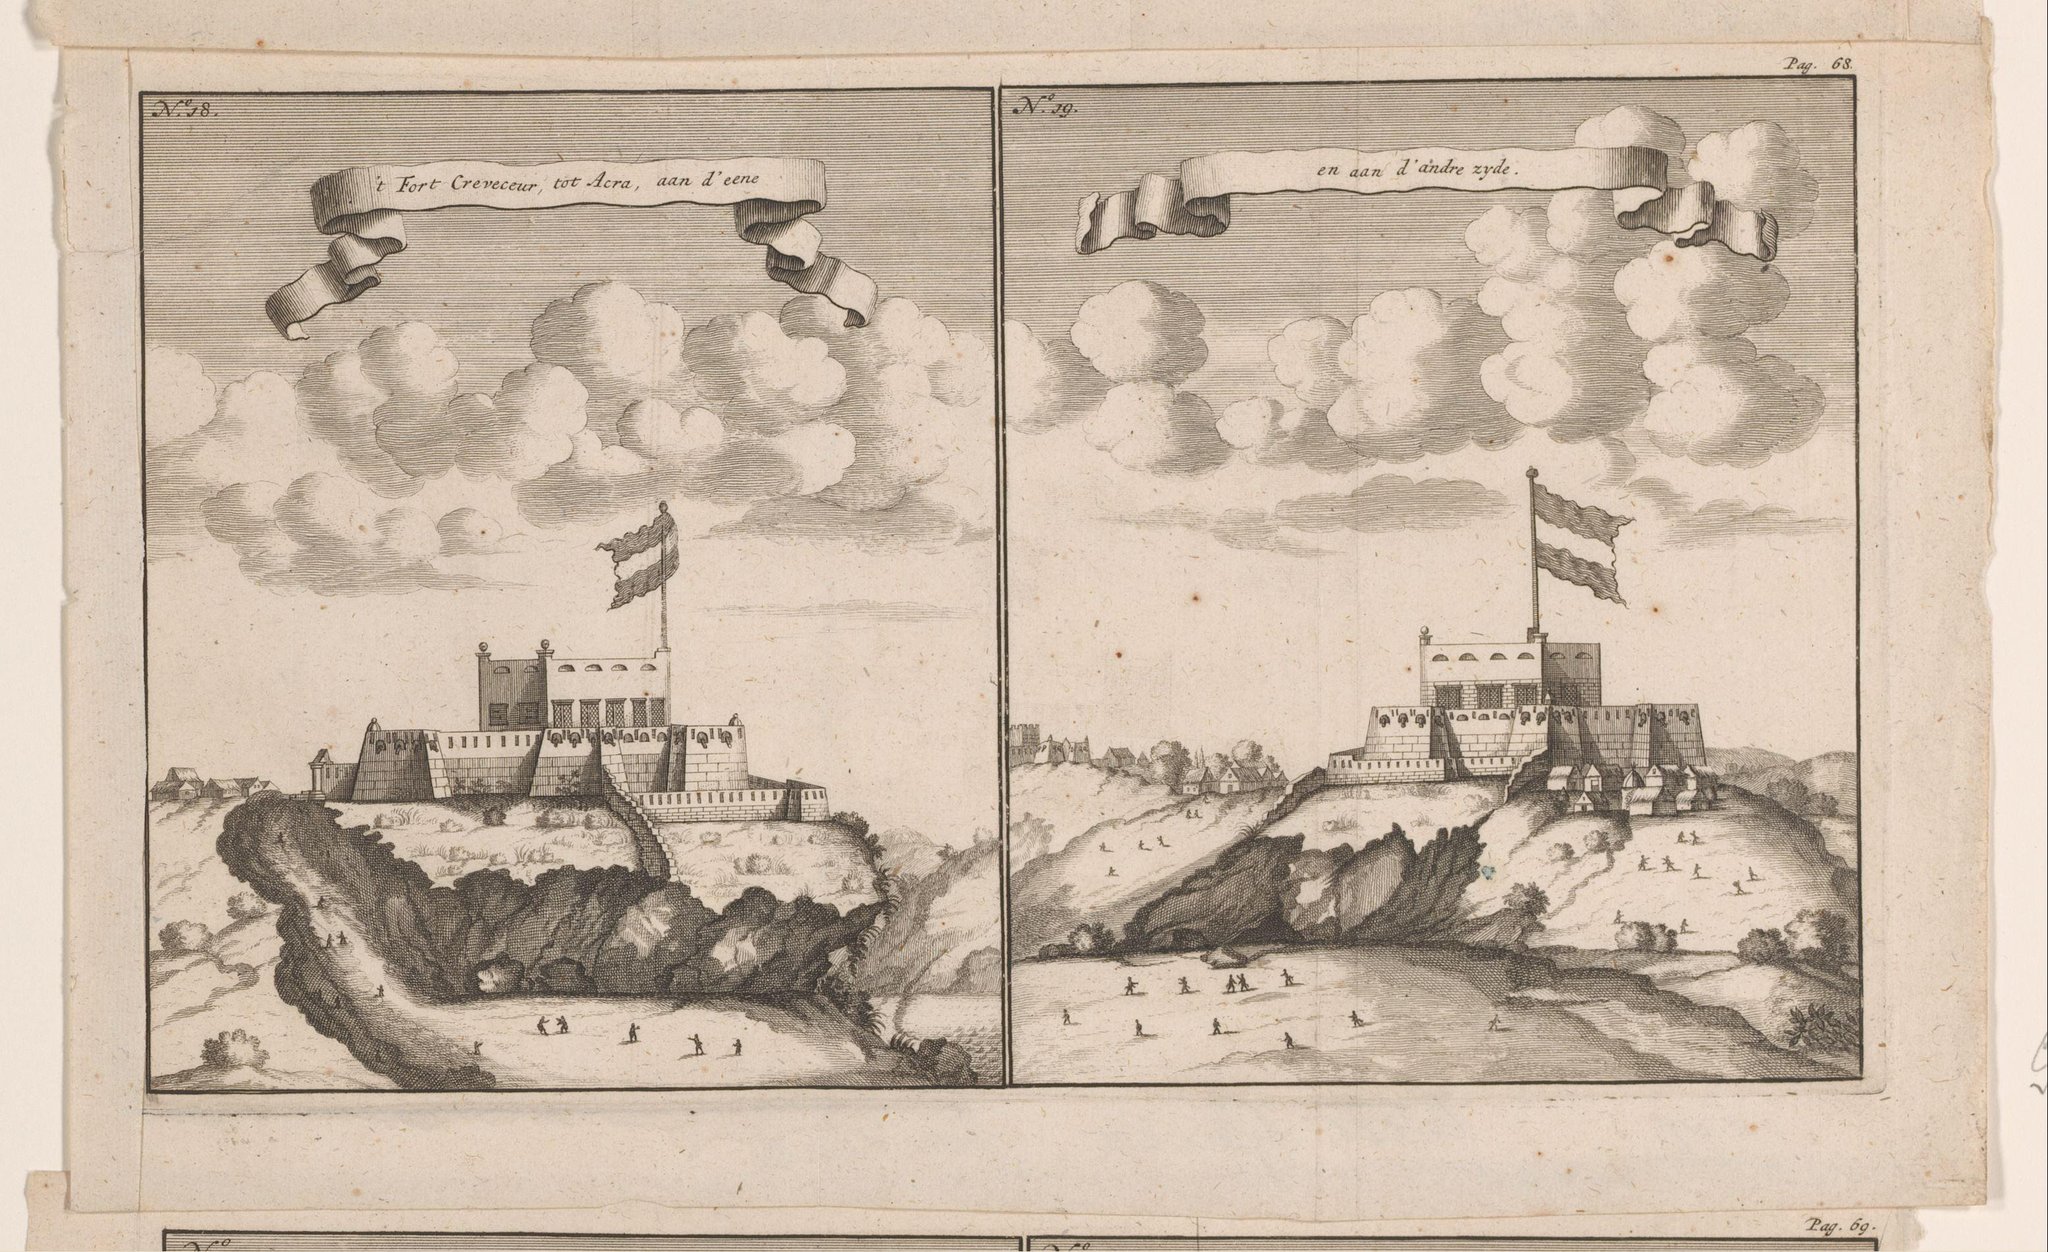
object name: book illustration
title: 't Fort Creveceur, tot Acra, aan d'eene / en aan d'andre zyde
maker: Anonymous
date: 1704-1737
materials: paper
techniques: etching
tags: fortress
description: Prent gebruikt in Willems Bosmans 'Nauwkeurige beschryving van de Guinese goud- tand- en slavekust', tussen 1704 en 1737 uitgegeven door verschillende uitgevers.